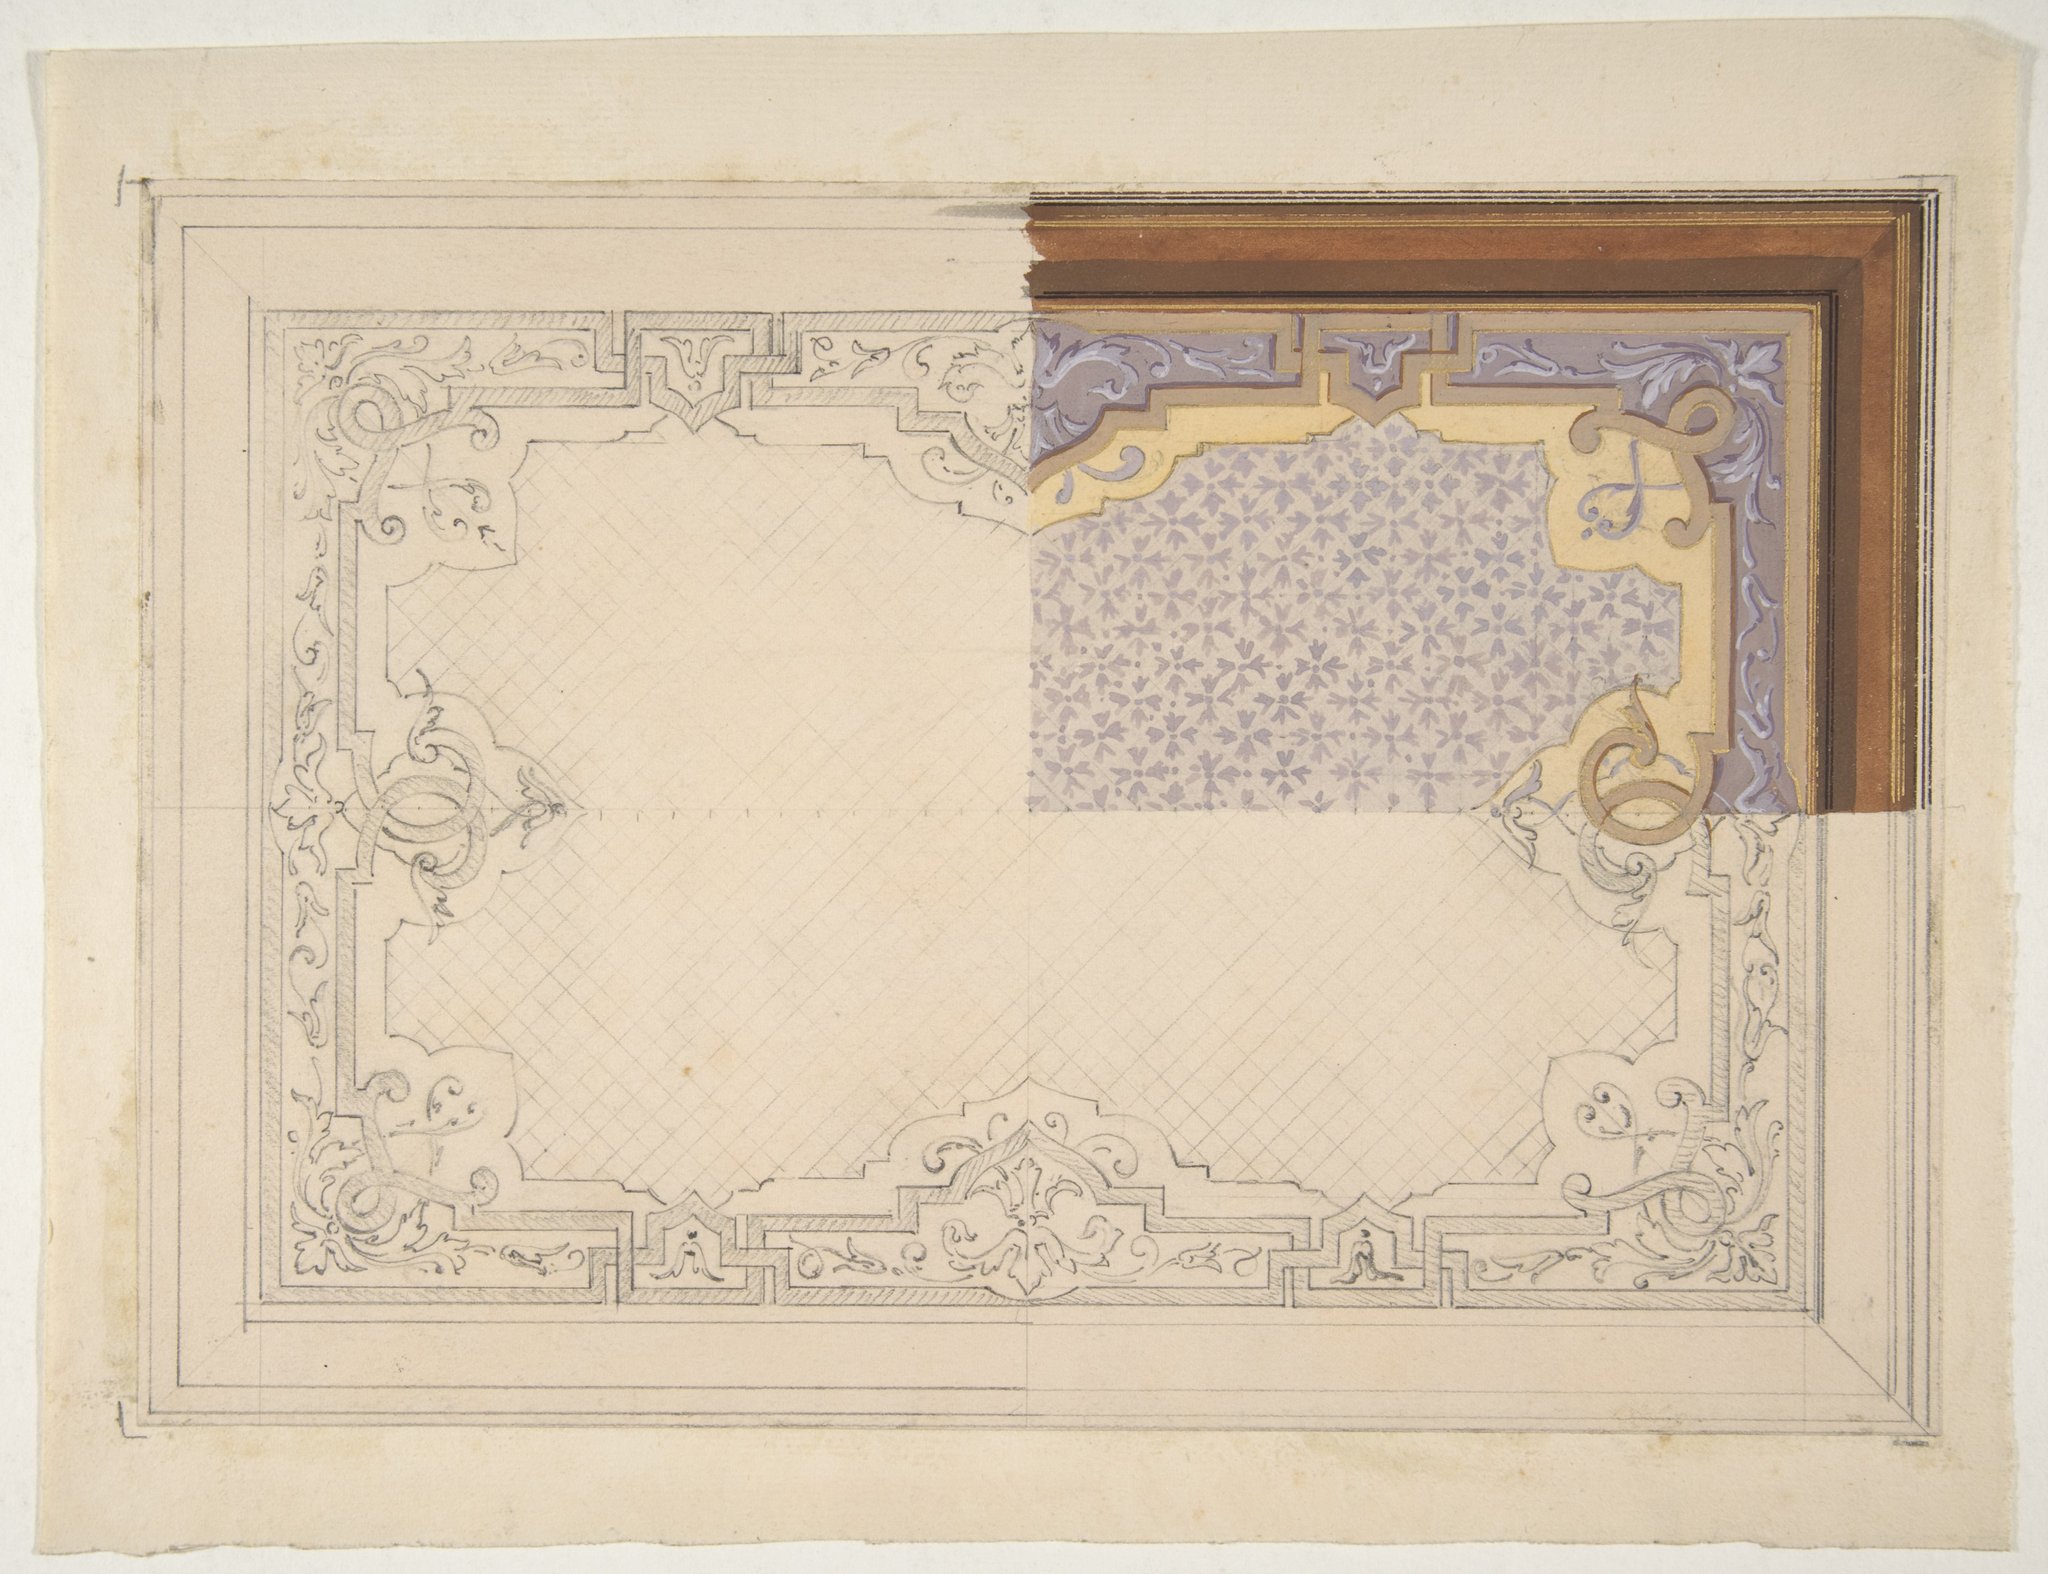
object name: drawing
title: Design for the painted decoration of a ceiling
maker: jules-edmond-charles lachaise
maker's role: artist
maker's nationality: french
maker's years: 1897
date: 1830-1897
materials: gold paint, graphite, paper, watercolor